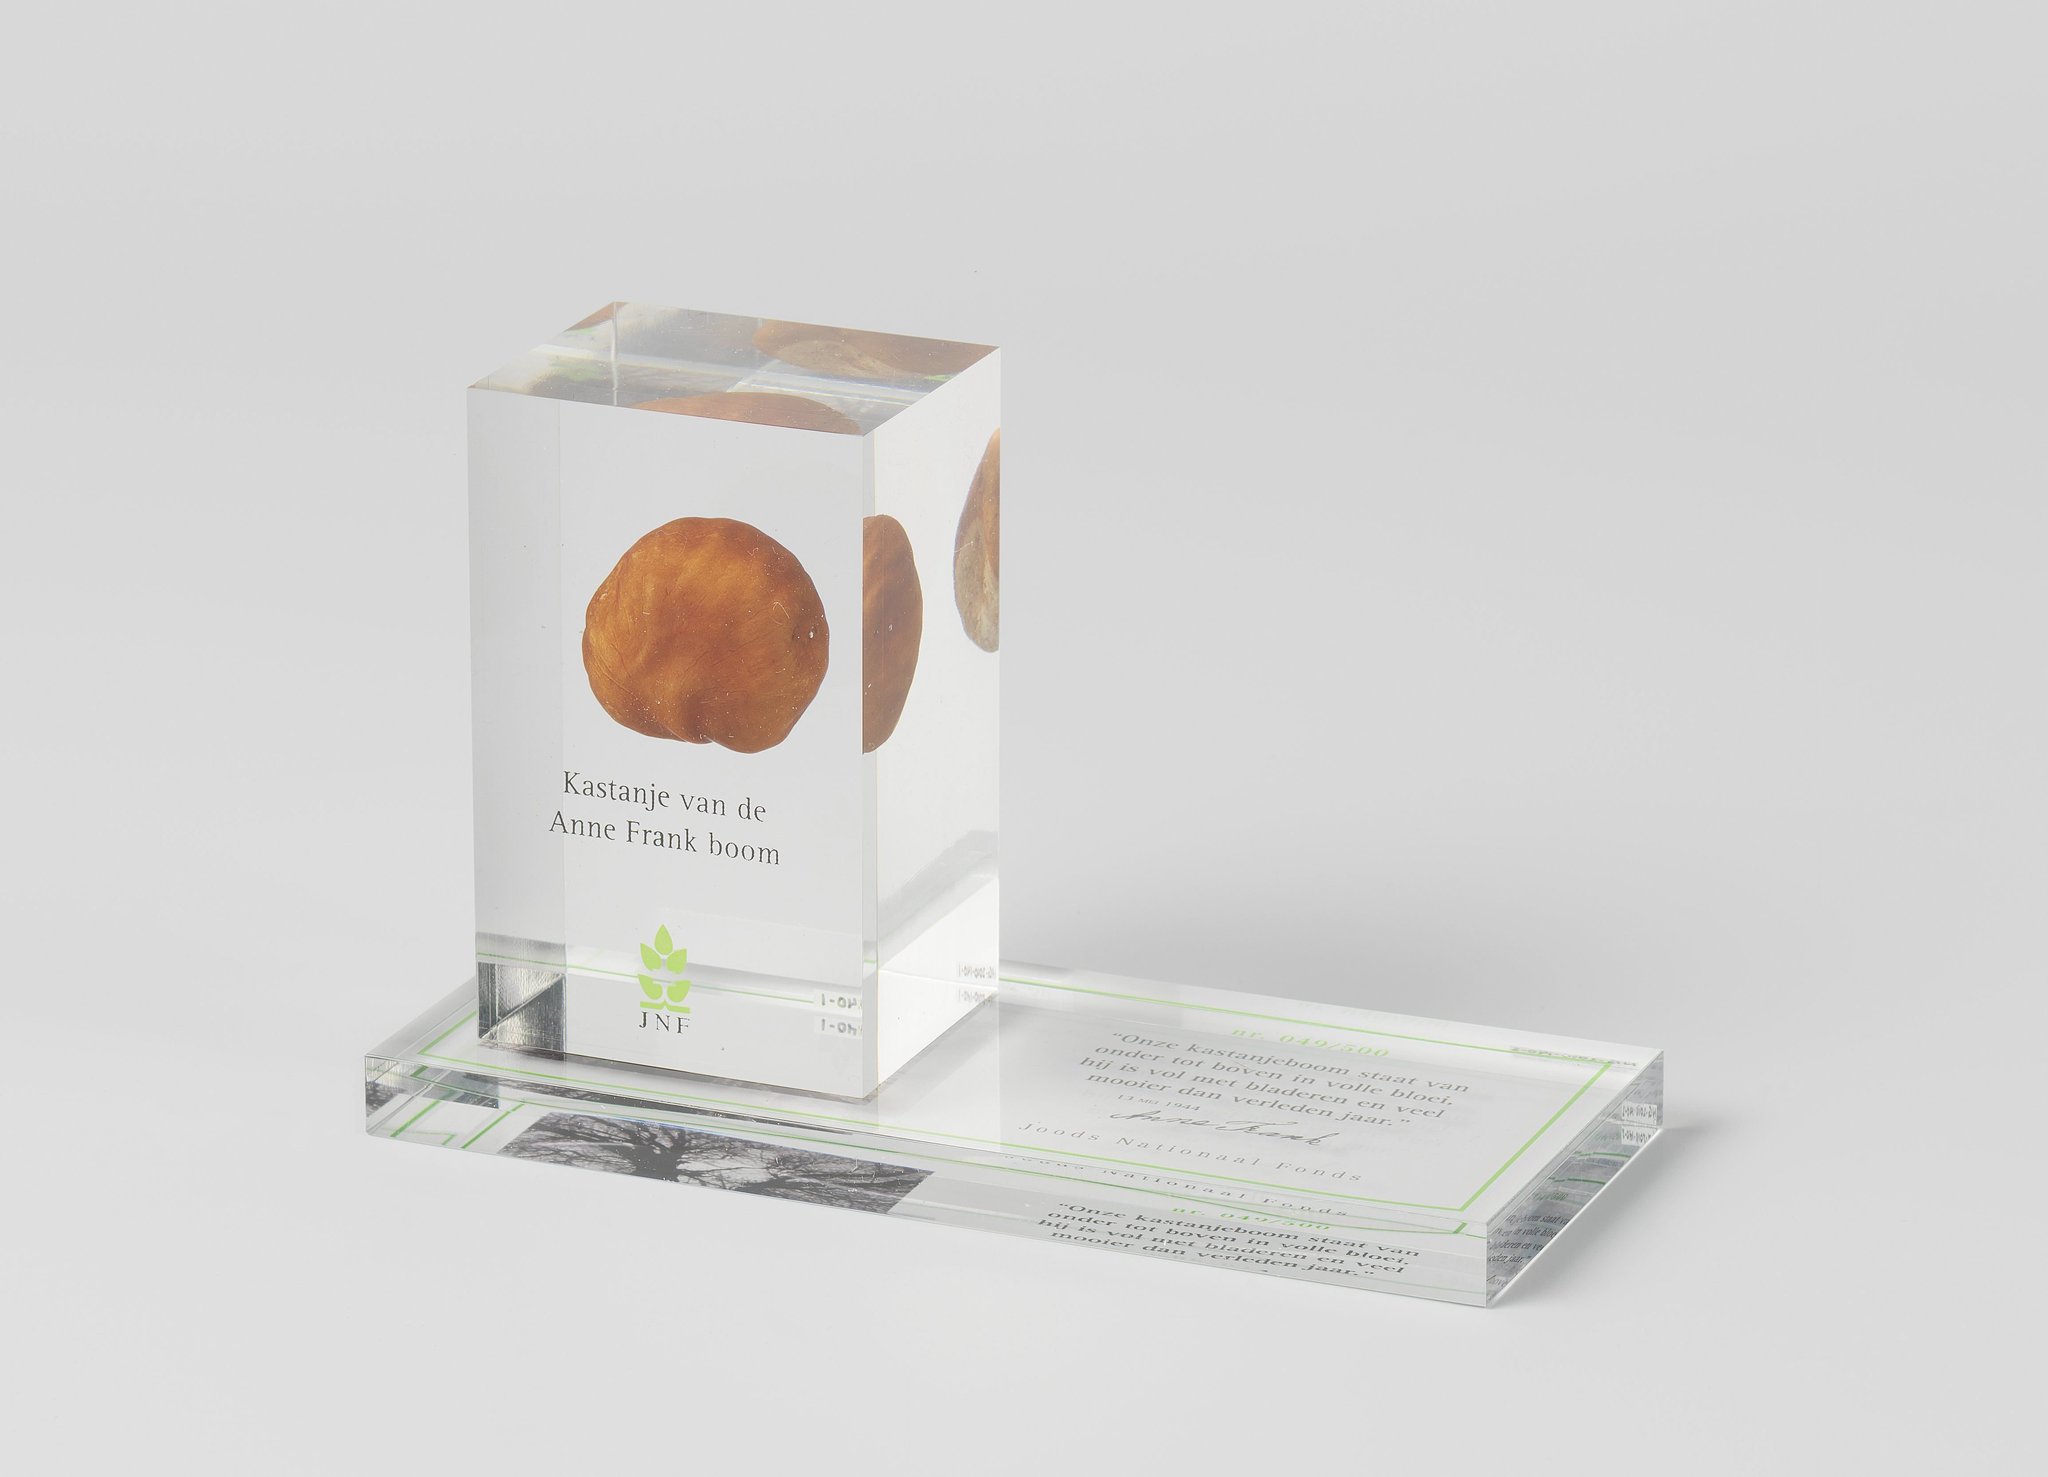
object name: commemorative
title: Plexiglazen plaat behorend bij kastanje Anne Frank boom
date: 2010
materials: plastic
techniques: casting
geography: netherlands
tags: anne frank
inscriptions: : ‘"Onze kastanjeboom staat van onder tot boven in volle bloei, hij is vol met bladeren en veel mooier dan verleden jaar." 13 mei 1944, Anne Frank’, : ‘nr. 049/500’, : ‘Joods Nationaal Fonds’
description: Plexiglazen plaat, waarin in zwart en groen een opdruk gevat.